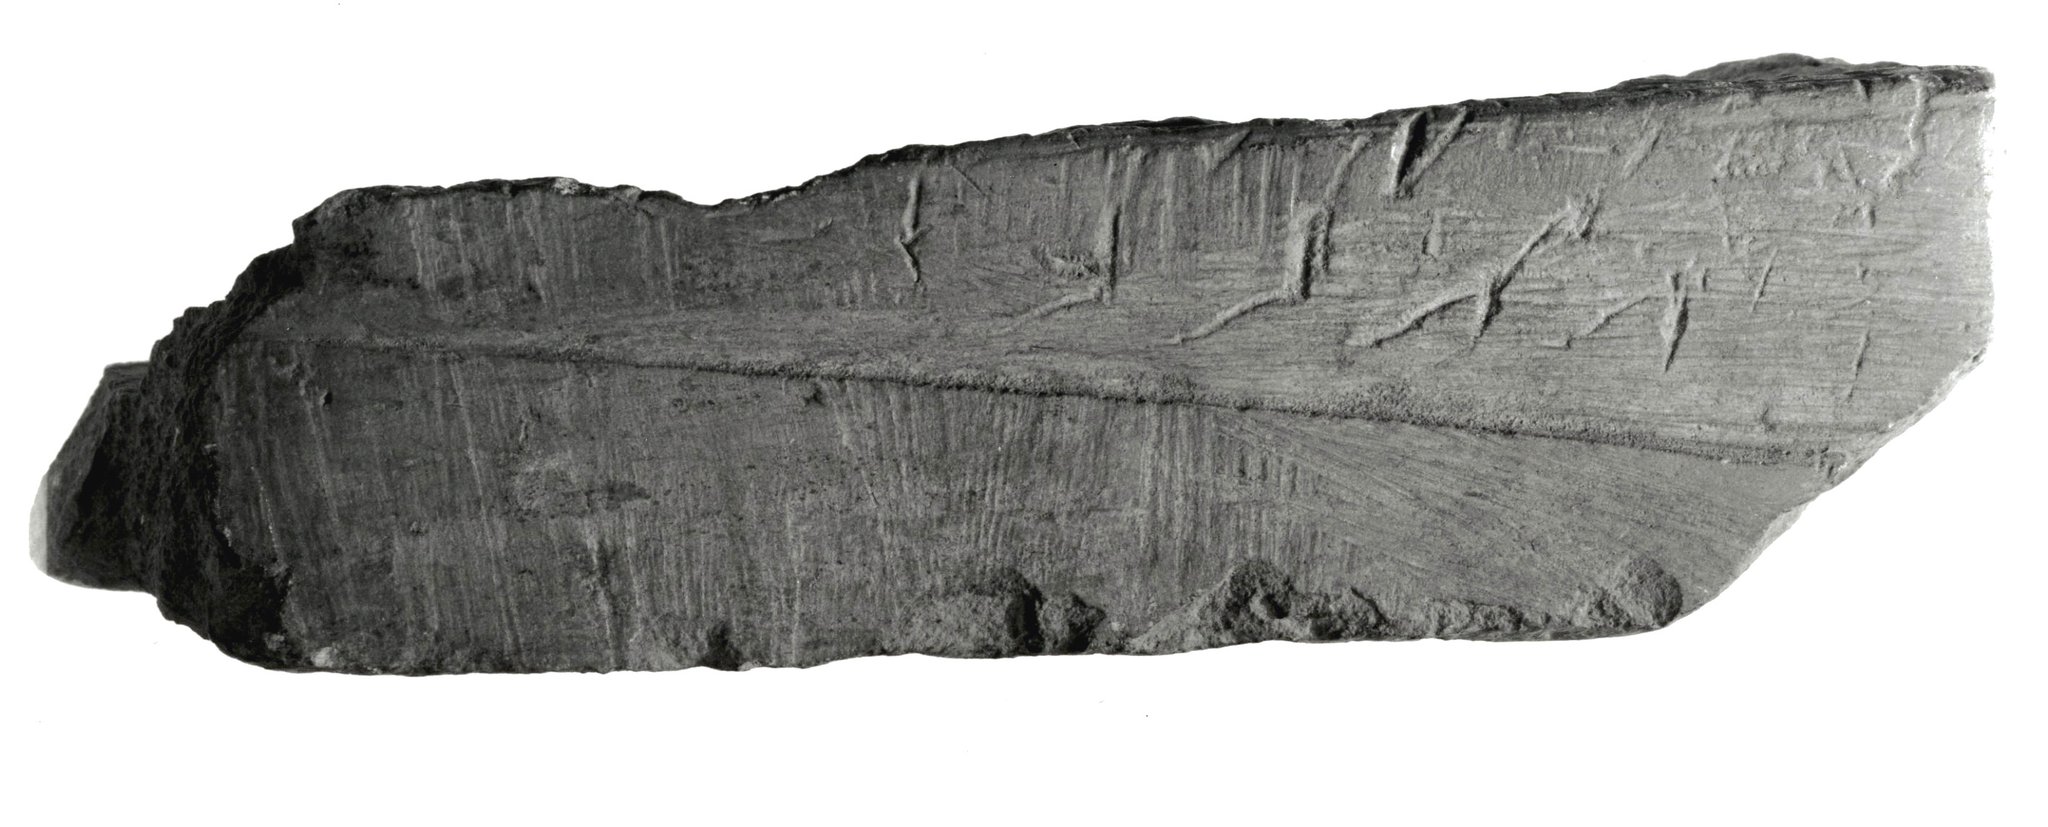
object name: relief, tomb of nespekashuty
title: Raised relief fragment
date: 664-610 BCE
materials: limestone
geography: egypt